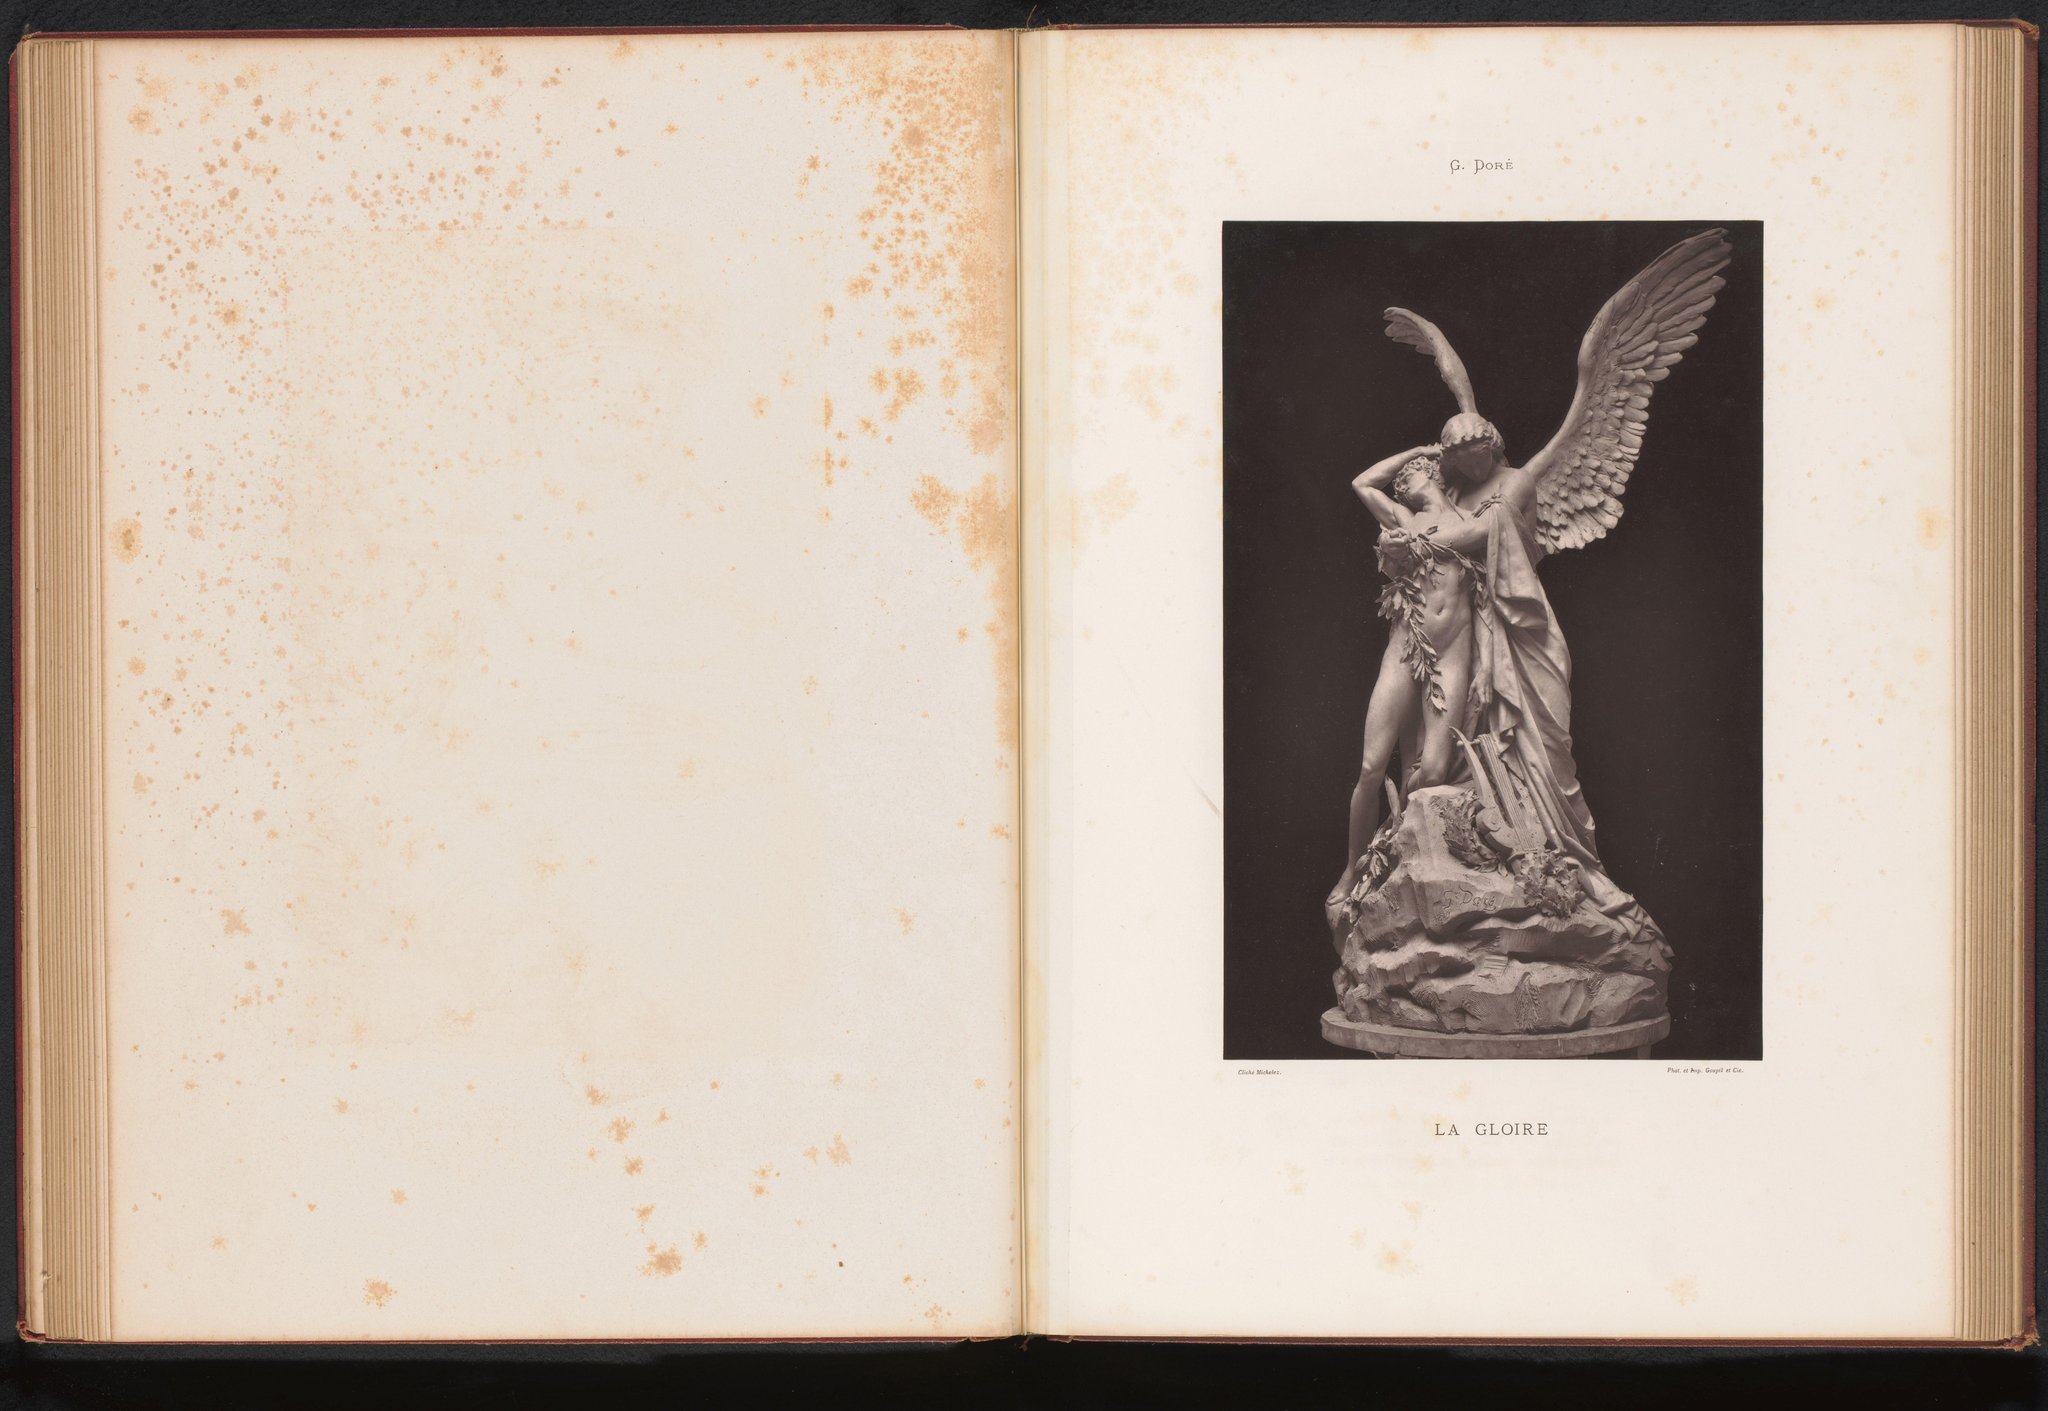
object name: page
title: Reproductie van La Gloire door Gustave Doré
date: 1874-1879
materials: paper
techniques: woodburytype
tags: sculpture, angels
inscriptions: name: ‘G. Doré’